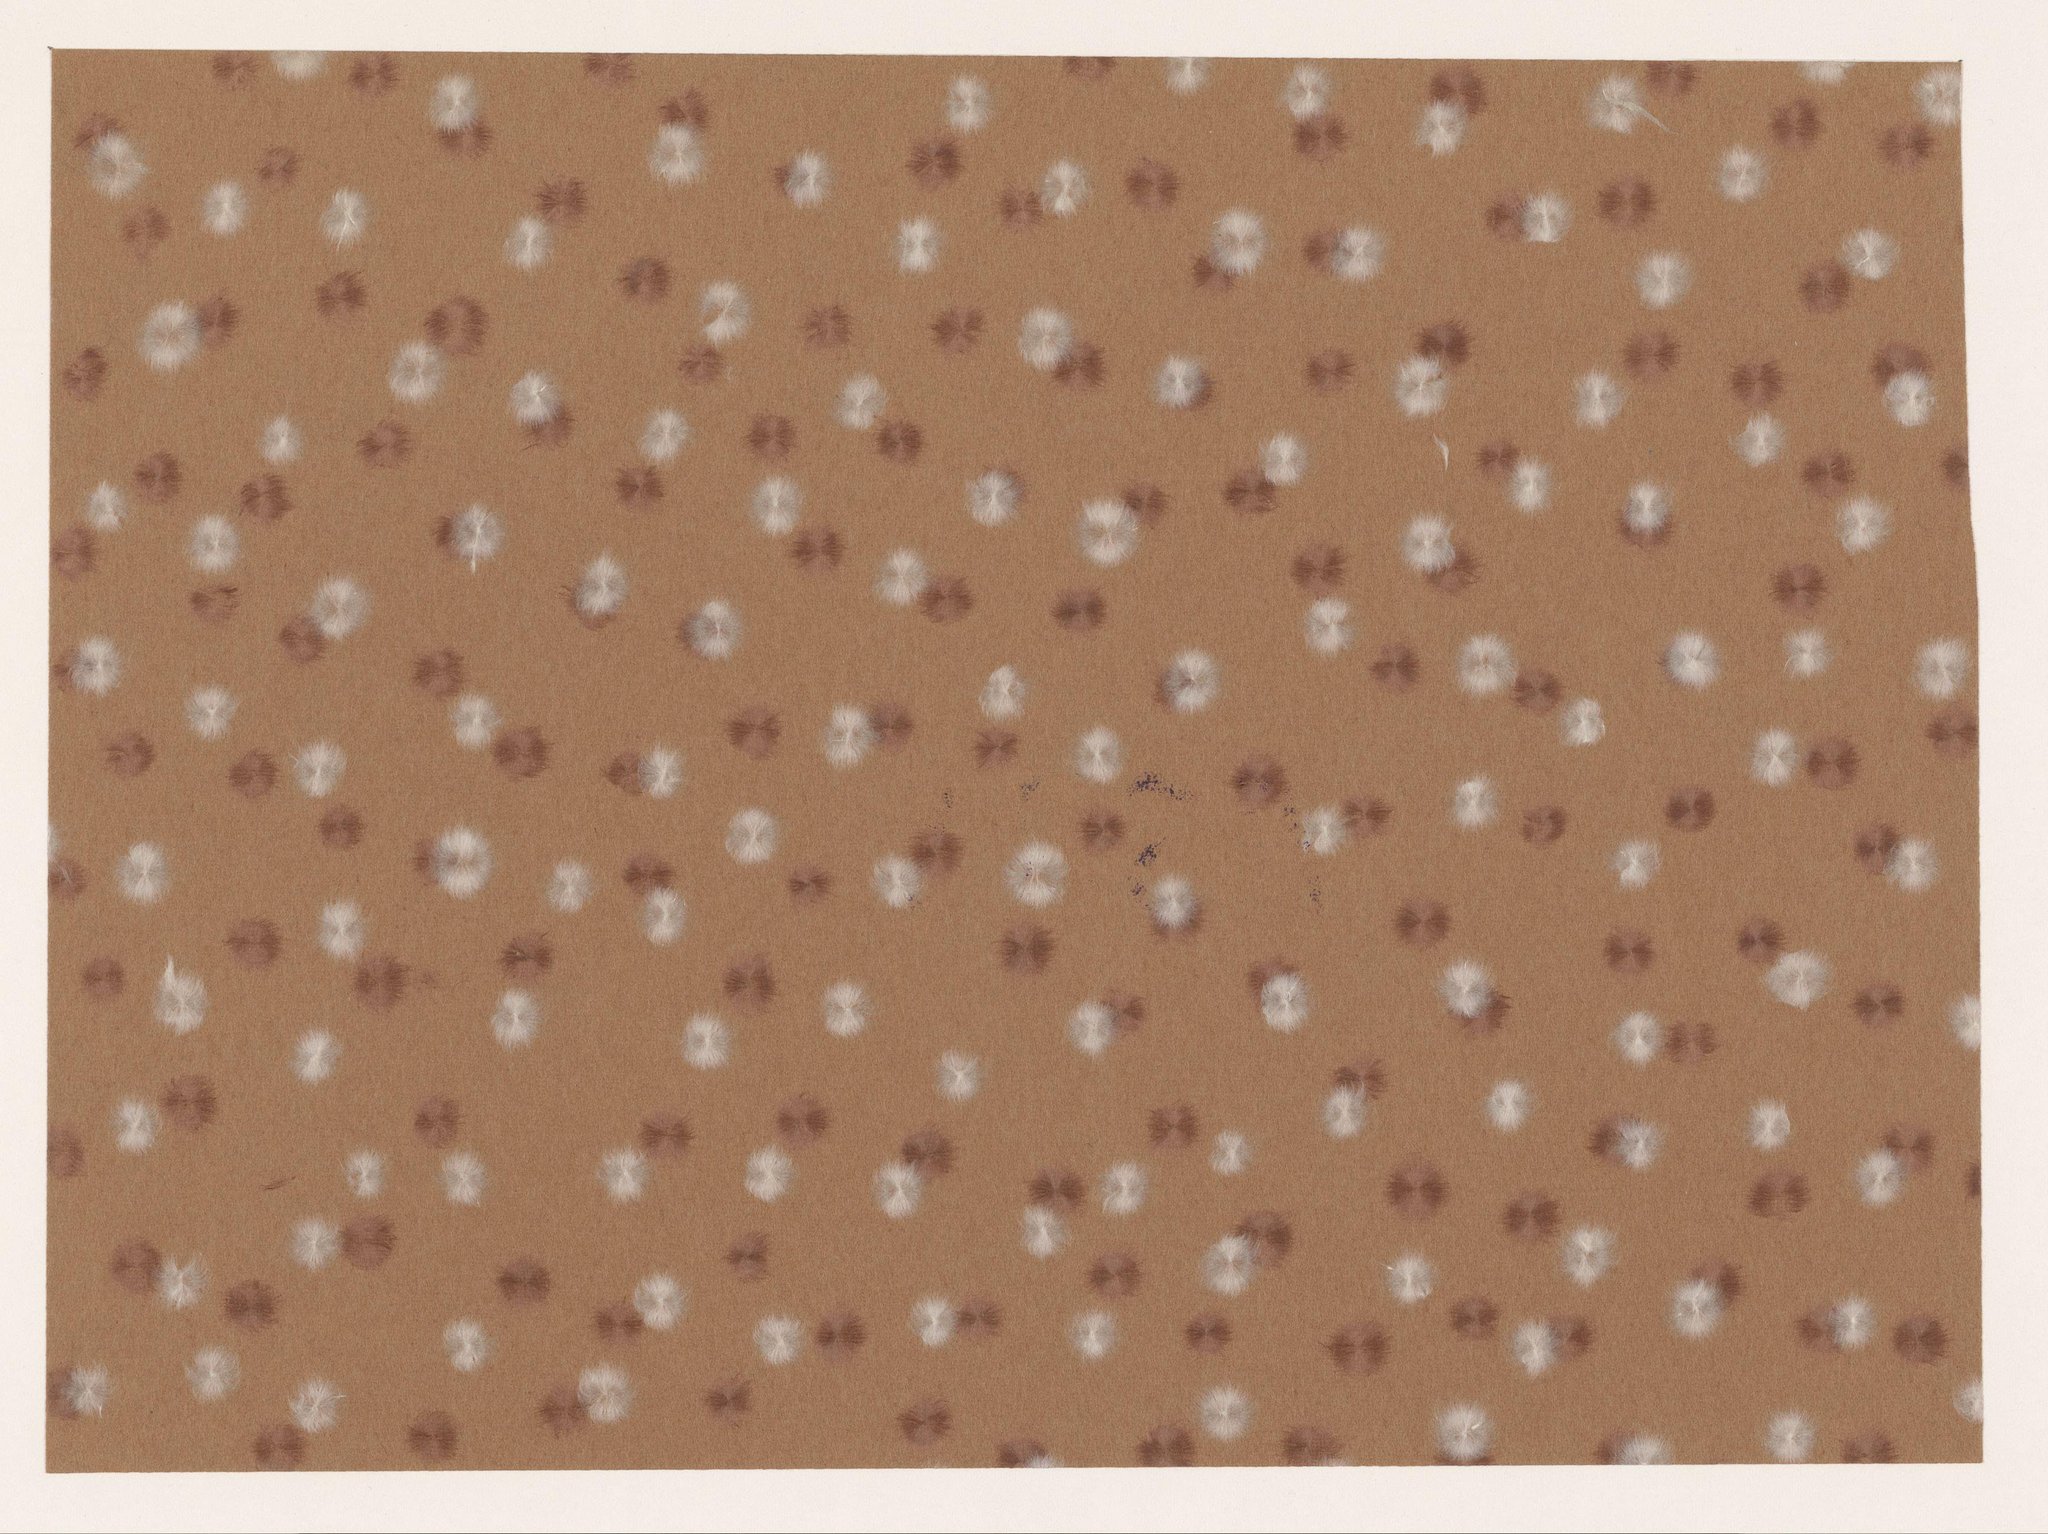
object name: decorated paper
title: Strooipatroon van bruine en witte ronde pluisjes op bruin papier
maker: Anonymous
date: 1974-1984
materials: paper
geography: japan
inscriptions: collector's mark: Lugt 2228